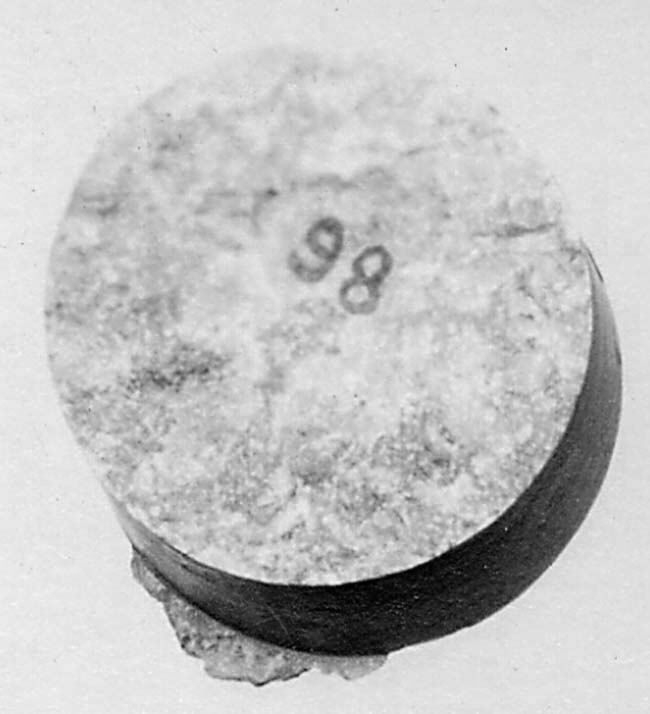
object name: fragment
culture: chinese or turkestani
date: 1902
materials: jade